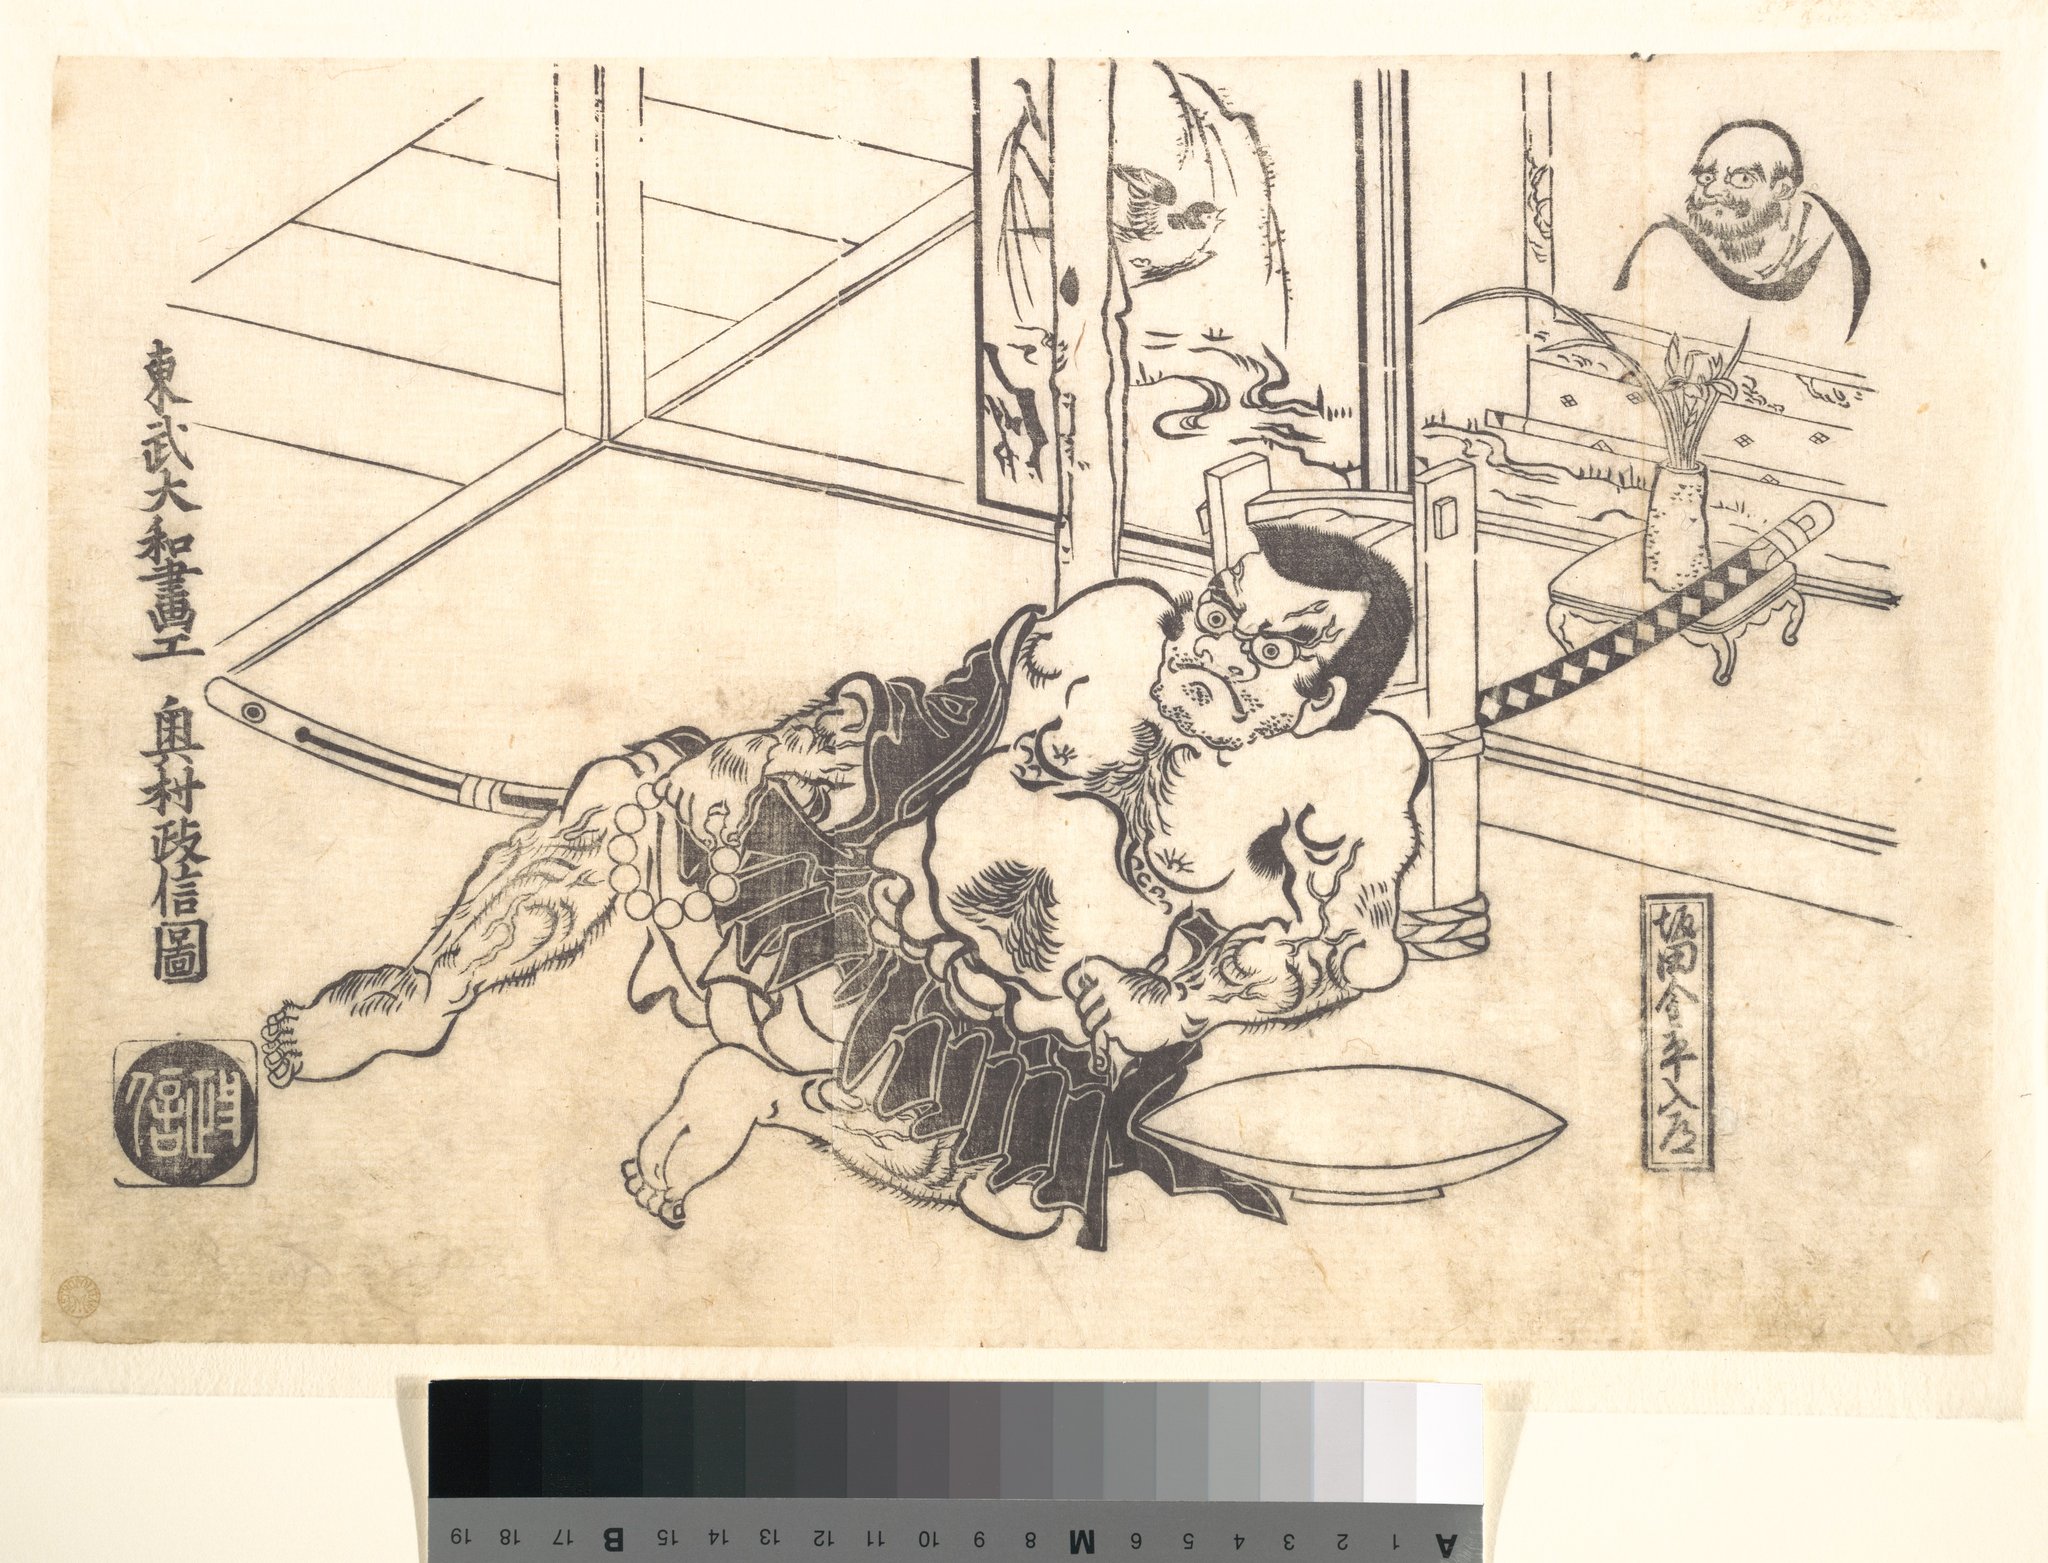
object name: print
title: Sakata Kinpira Nyudo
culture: japanese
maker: okumura masanobu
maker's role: artist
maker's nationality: japanese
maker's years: 1686-1764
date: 1701-1733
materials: ink, paper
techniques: woodblock print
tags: swords,men